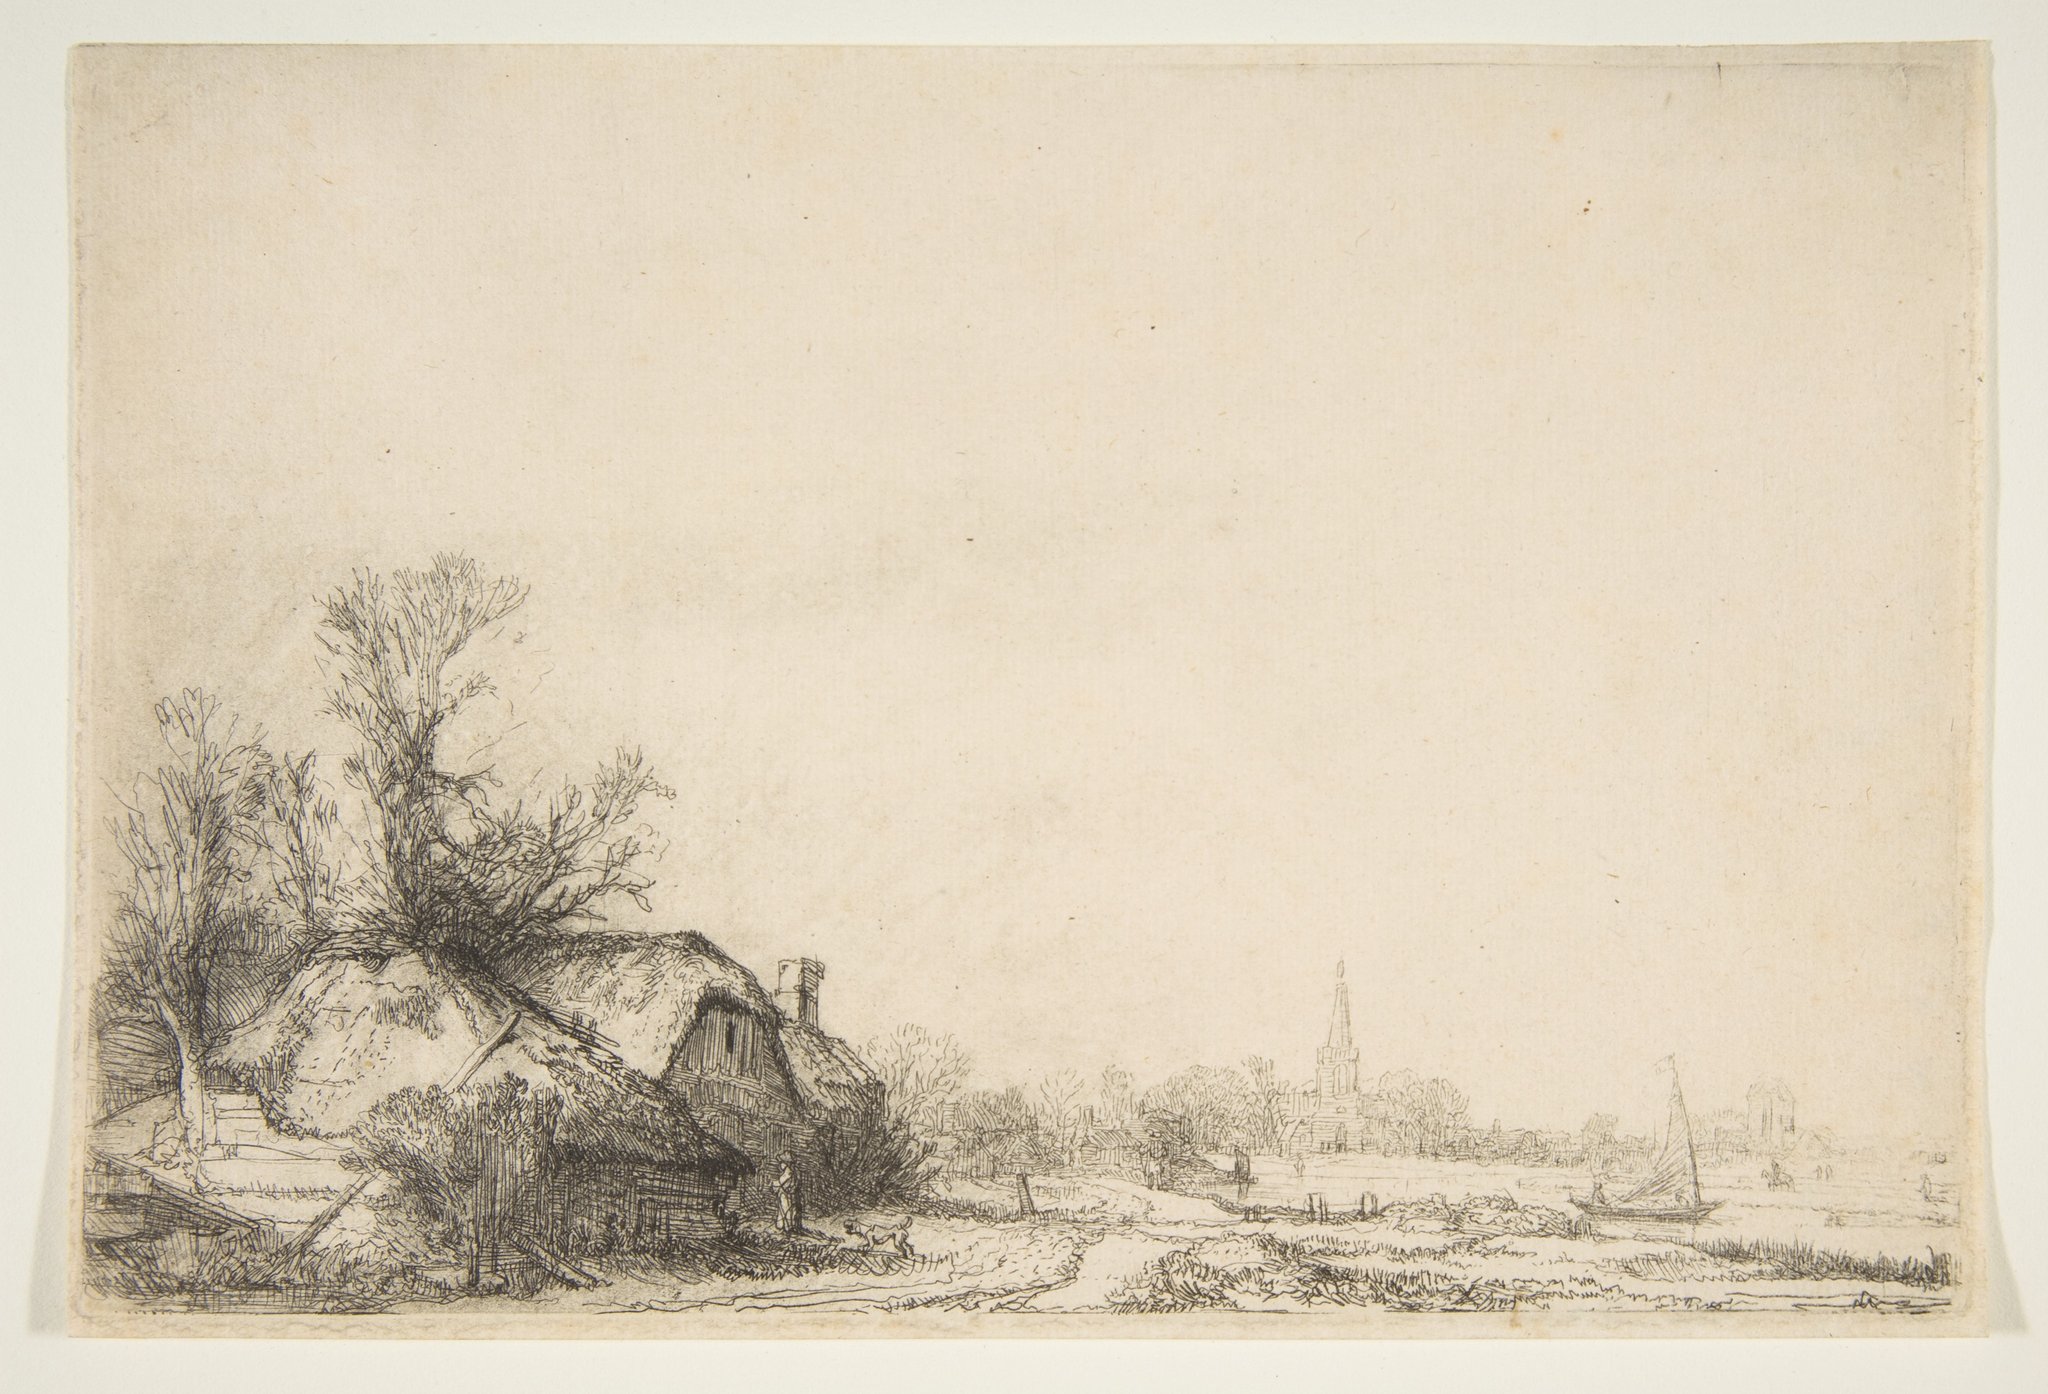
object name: print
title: Cottage beside a Canal with a View of Ouderkerk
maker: rembrandt van rijn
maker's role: artist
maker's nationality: dutch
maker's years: 1606-1669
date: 1641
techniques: drypoint, etching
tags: houses,canals,trees,boats